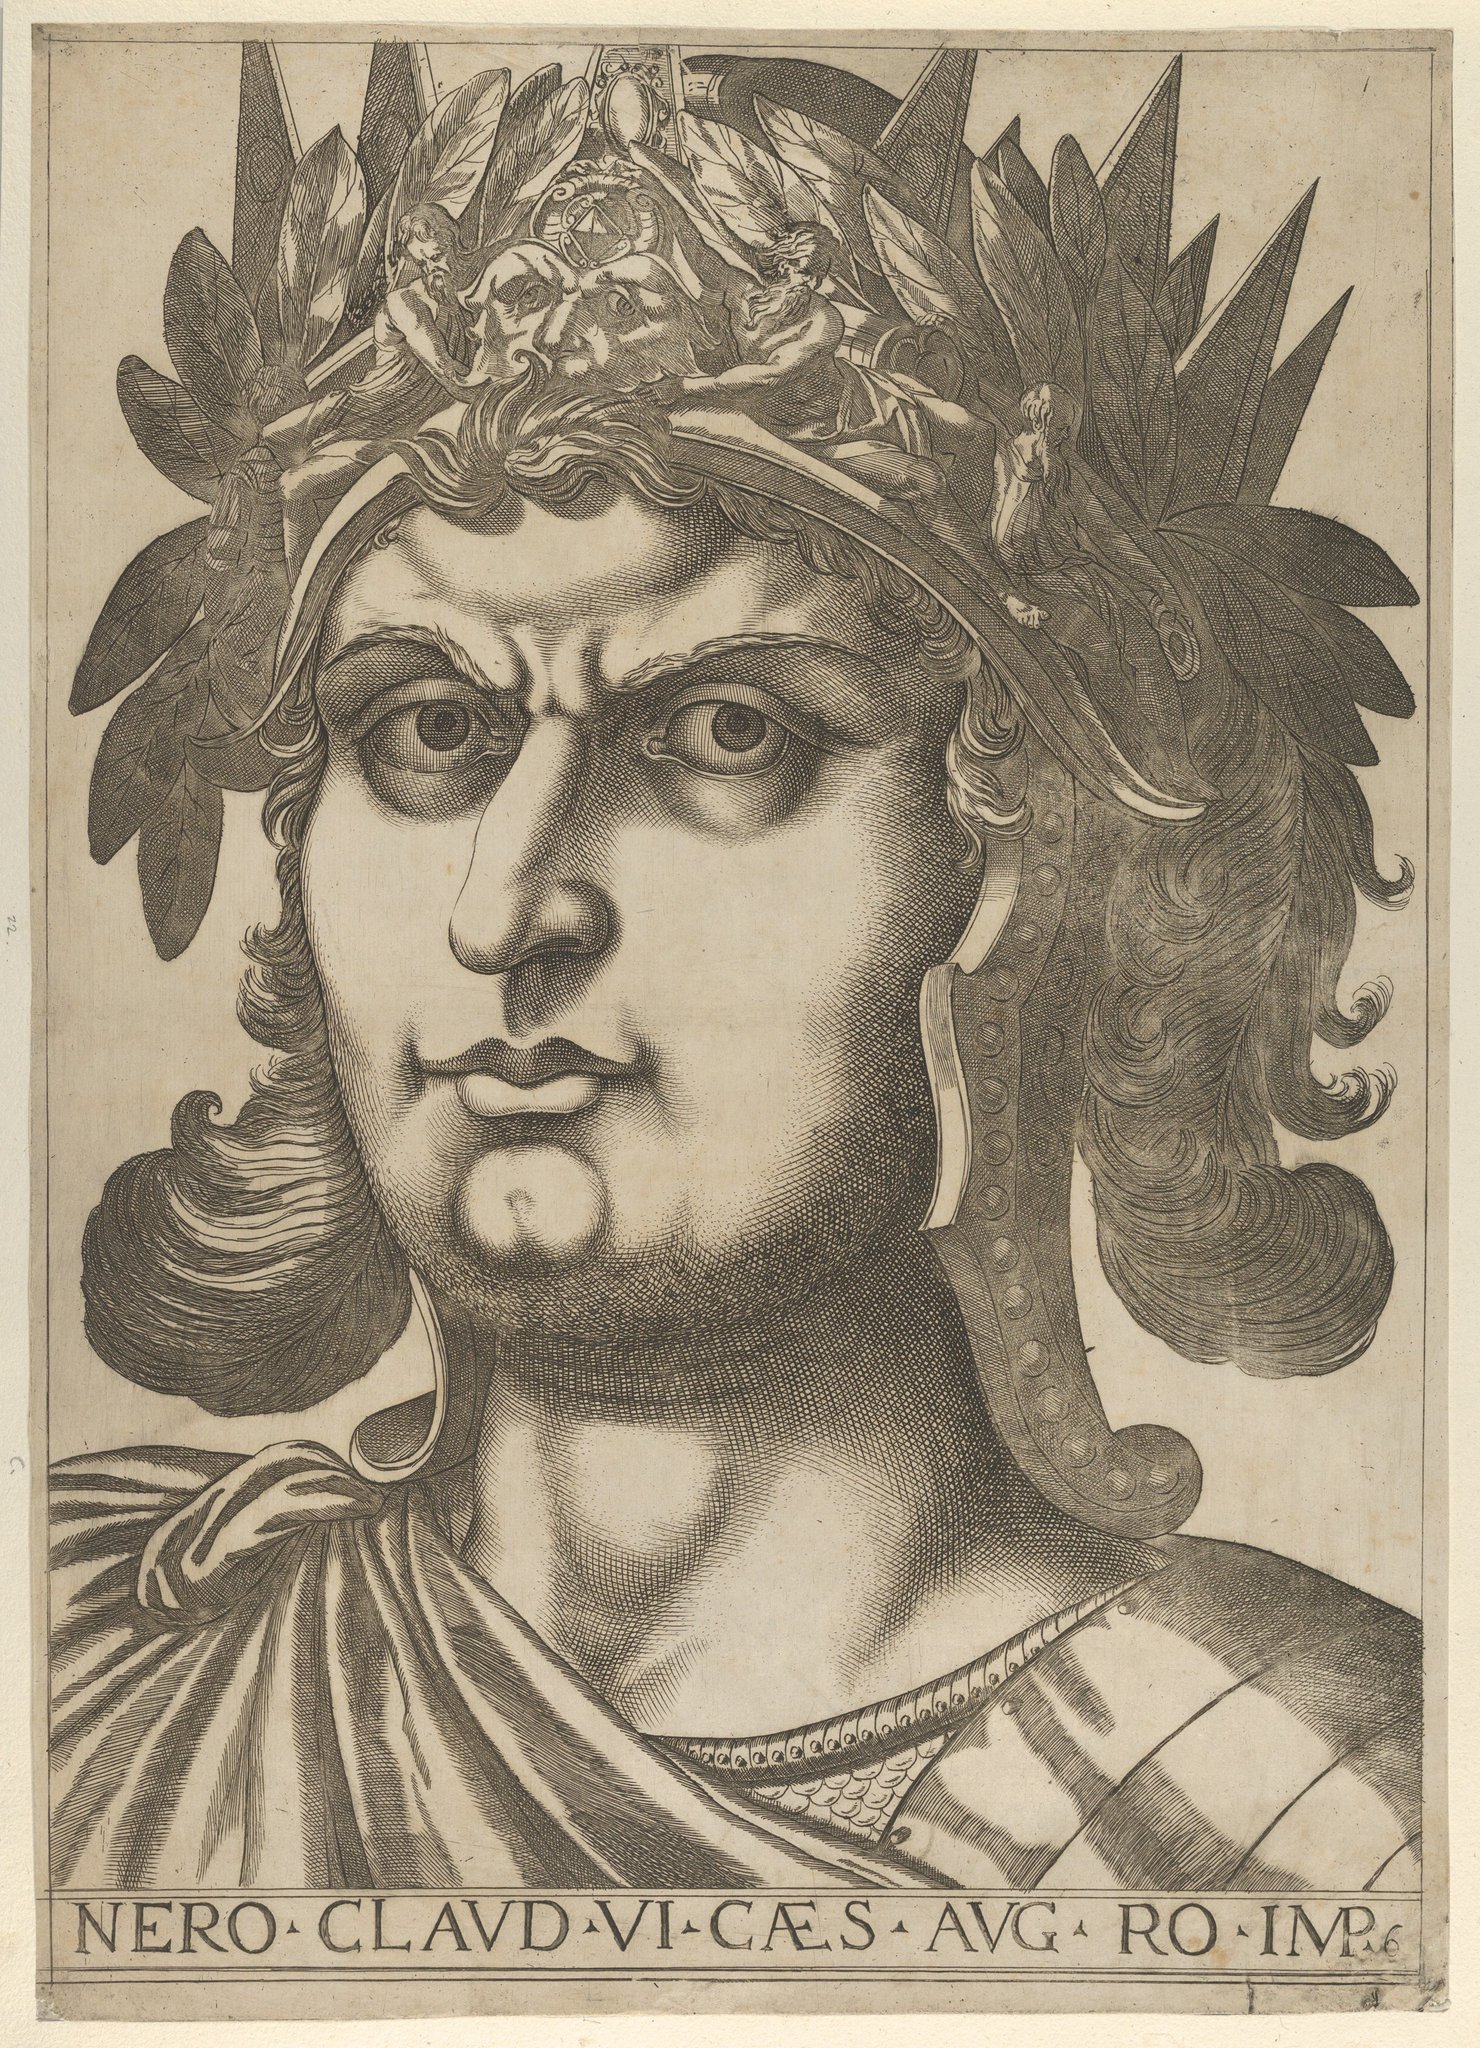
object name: print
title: Plate 6: Nero with his head turned slightly to the right, from "The Twelve Caesars"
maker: Anonymous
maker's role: artist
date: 1610-1640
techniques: engraving, etching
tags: helmets,nero,men